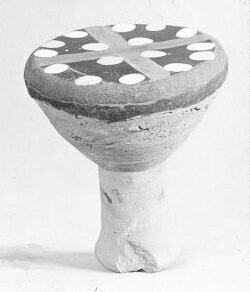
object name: agwel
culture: moroccan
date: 1867-1900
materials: clay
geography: morocco